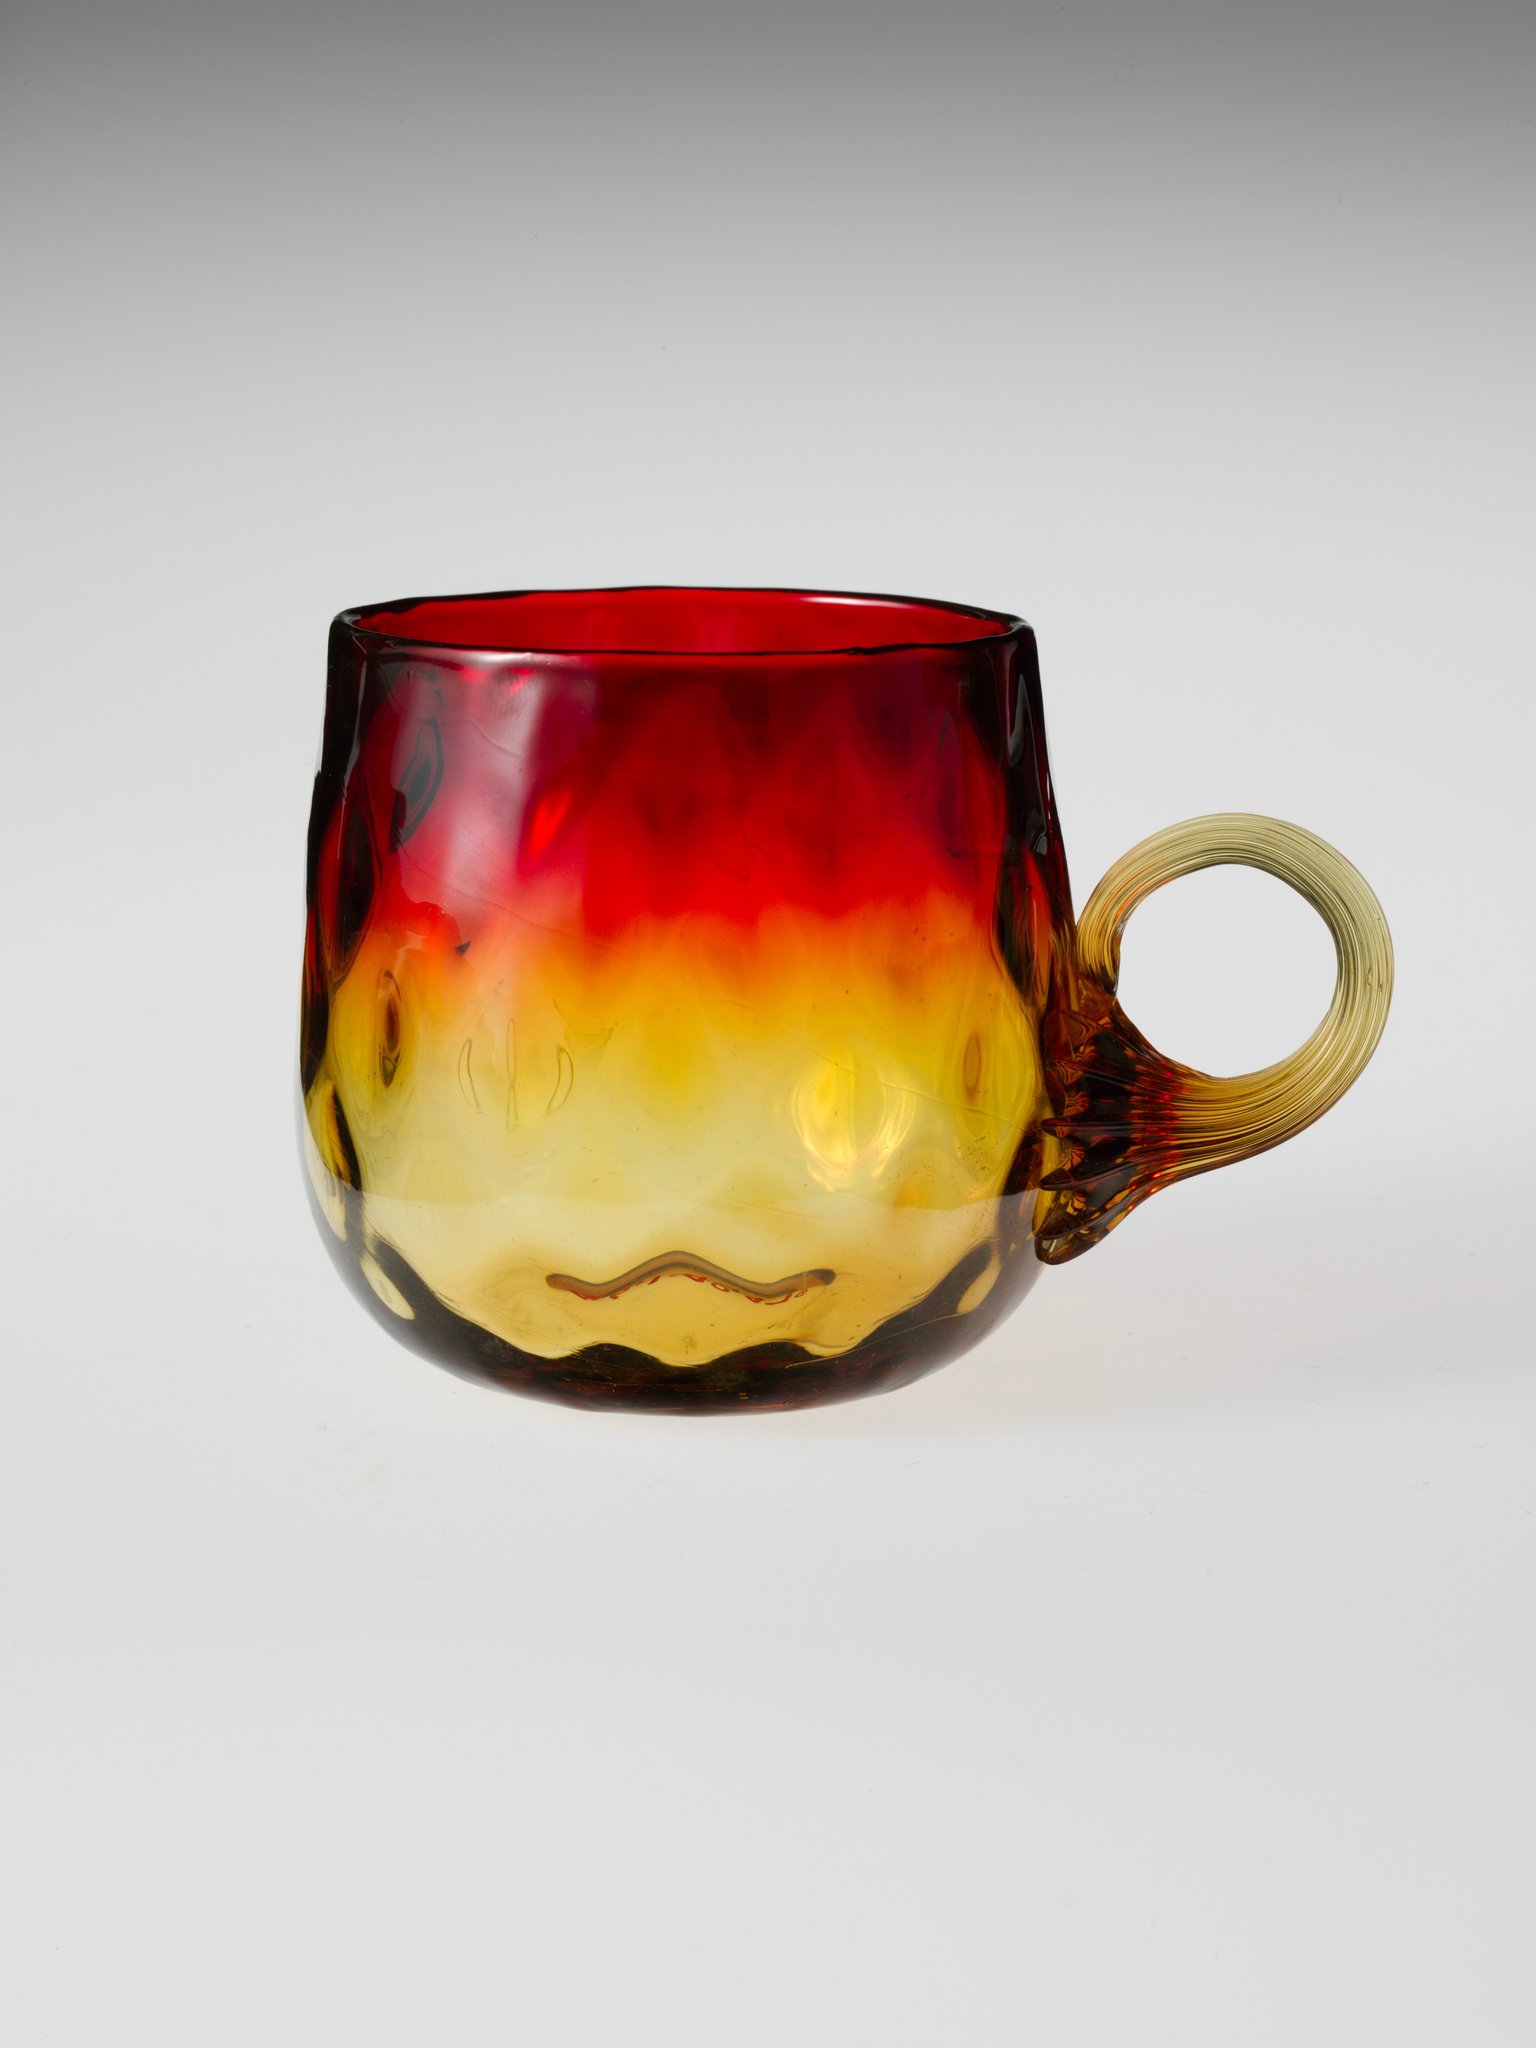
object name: cup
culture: american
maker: new england glass company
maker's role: maker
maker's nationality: american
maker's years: 1818-1888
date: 1801-1900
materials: glass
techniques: glassblowing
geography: united states